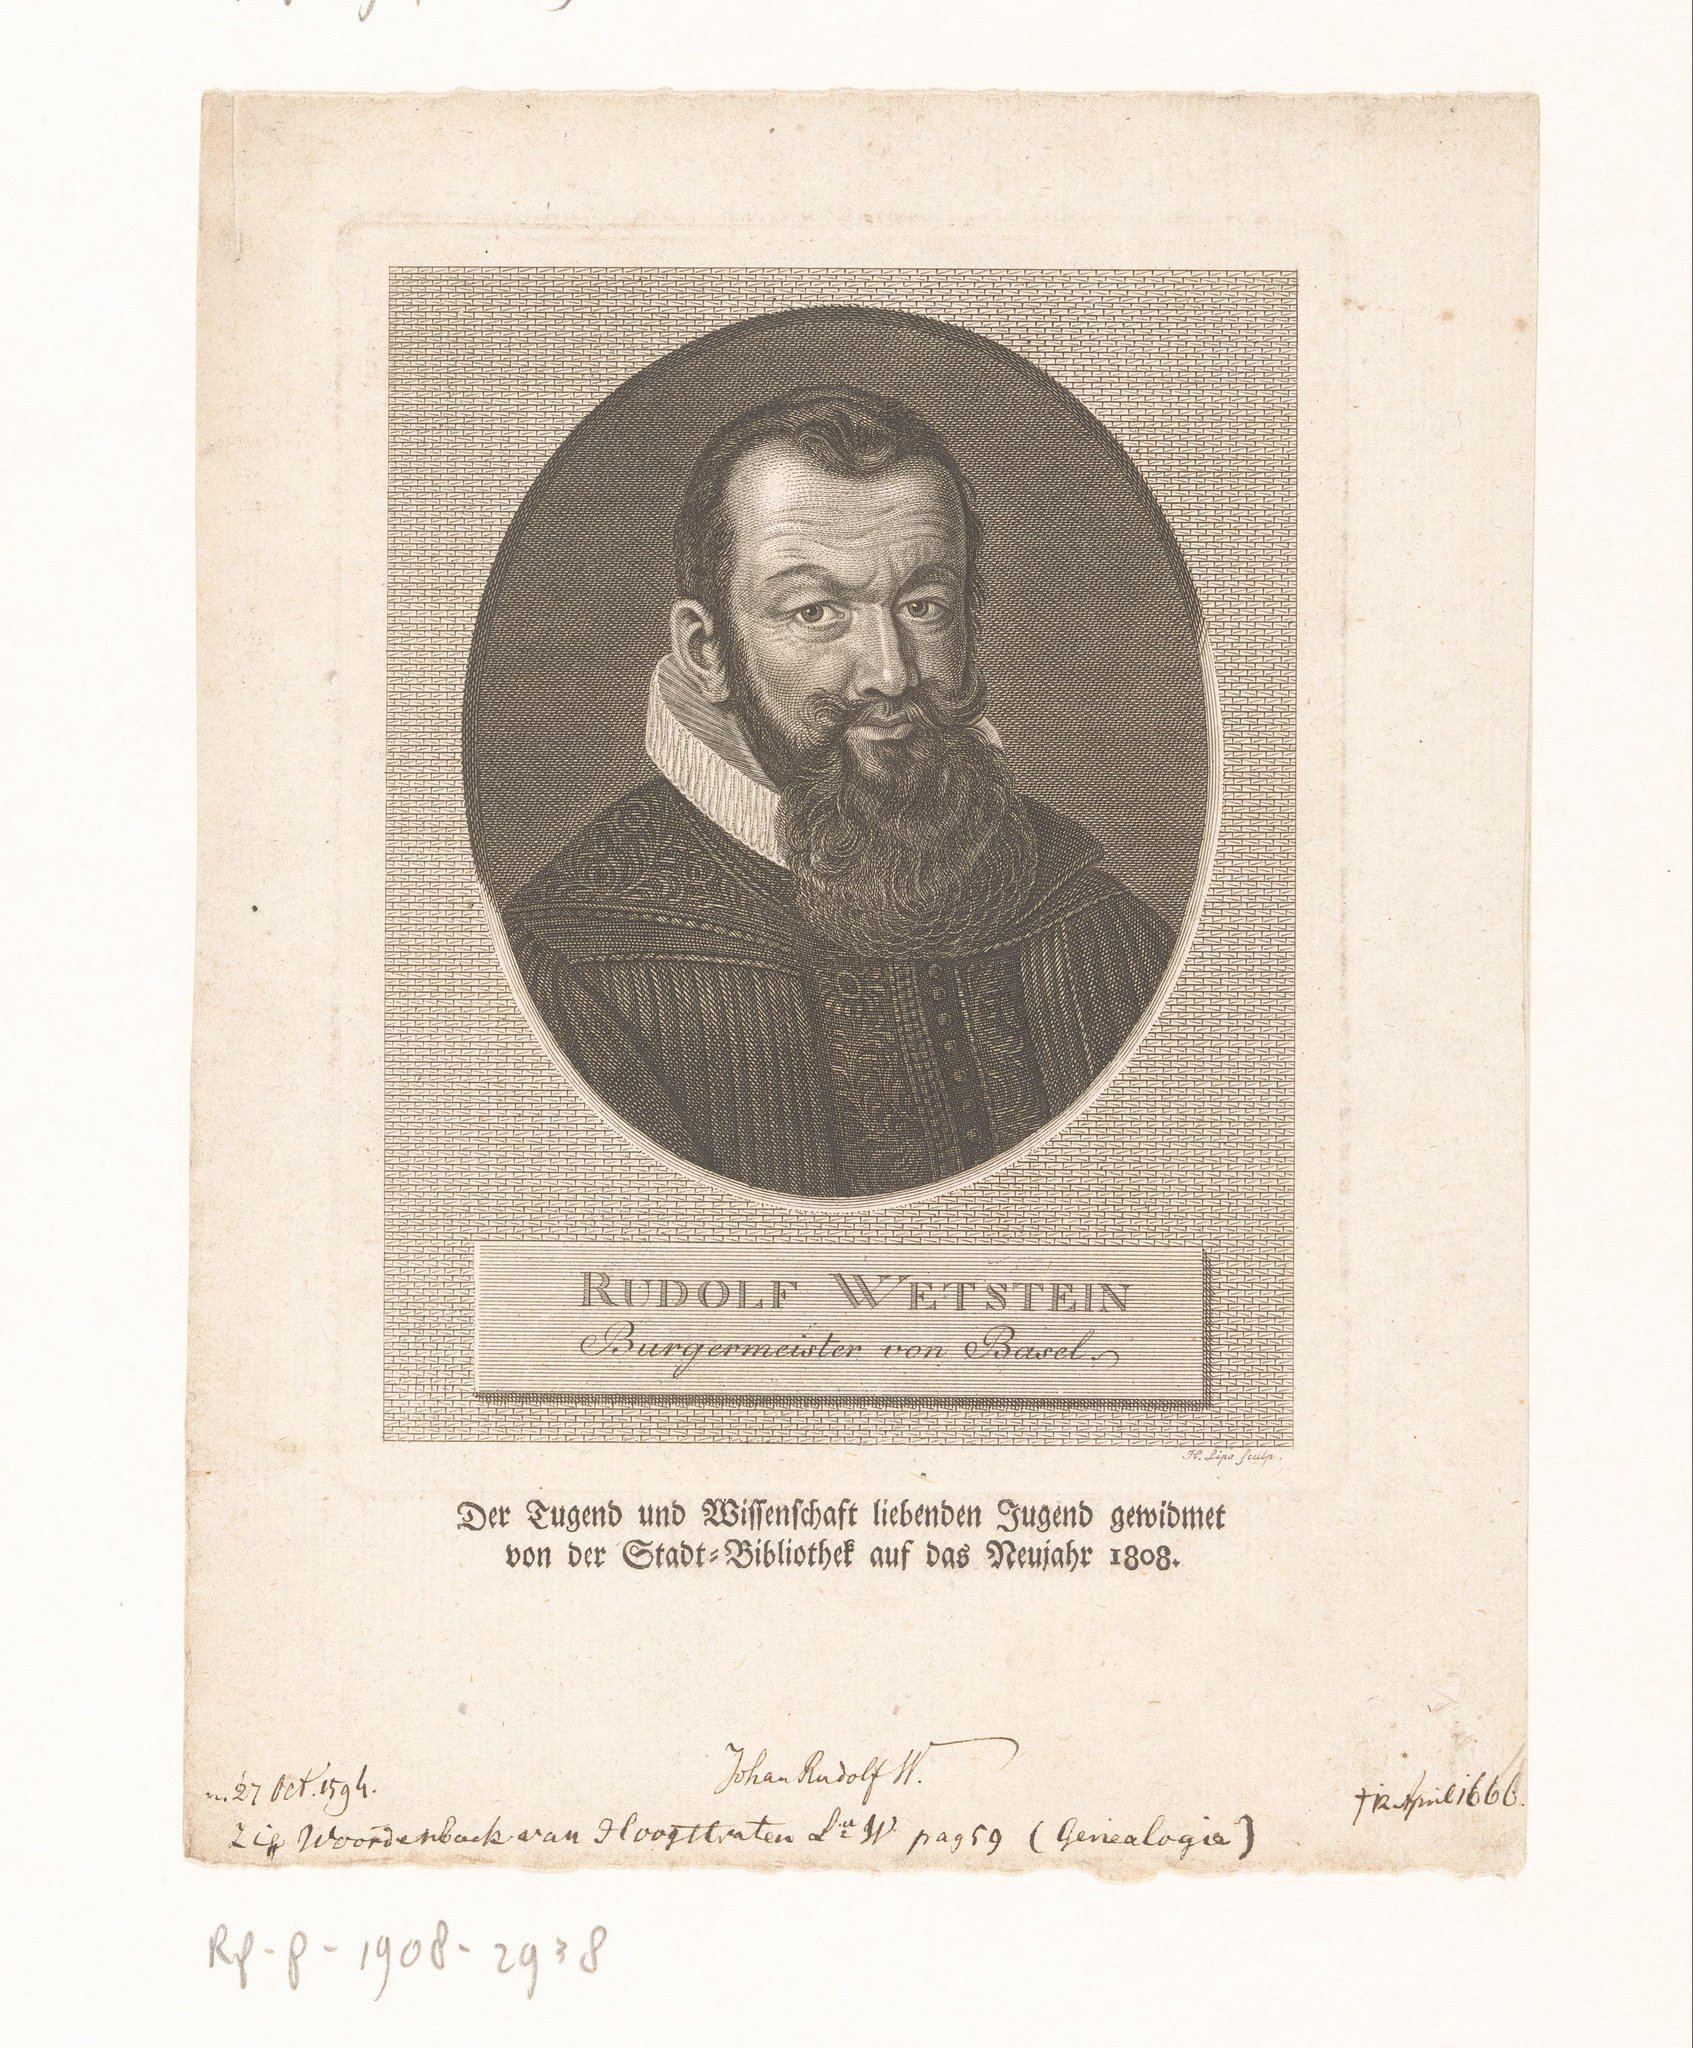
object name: print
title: Portret van Rudolph Wetstein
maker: johann heinrich lips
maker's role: draughtsman, painter, print maker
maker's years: 1758-1817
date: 1808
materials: paper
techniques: engraving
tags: publisher, rudolph wetstein, mayor, burgomaster, historical persons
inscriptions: collector's mark: Lugt 2228